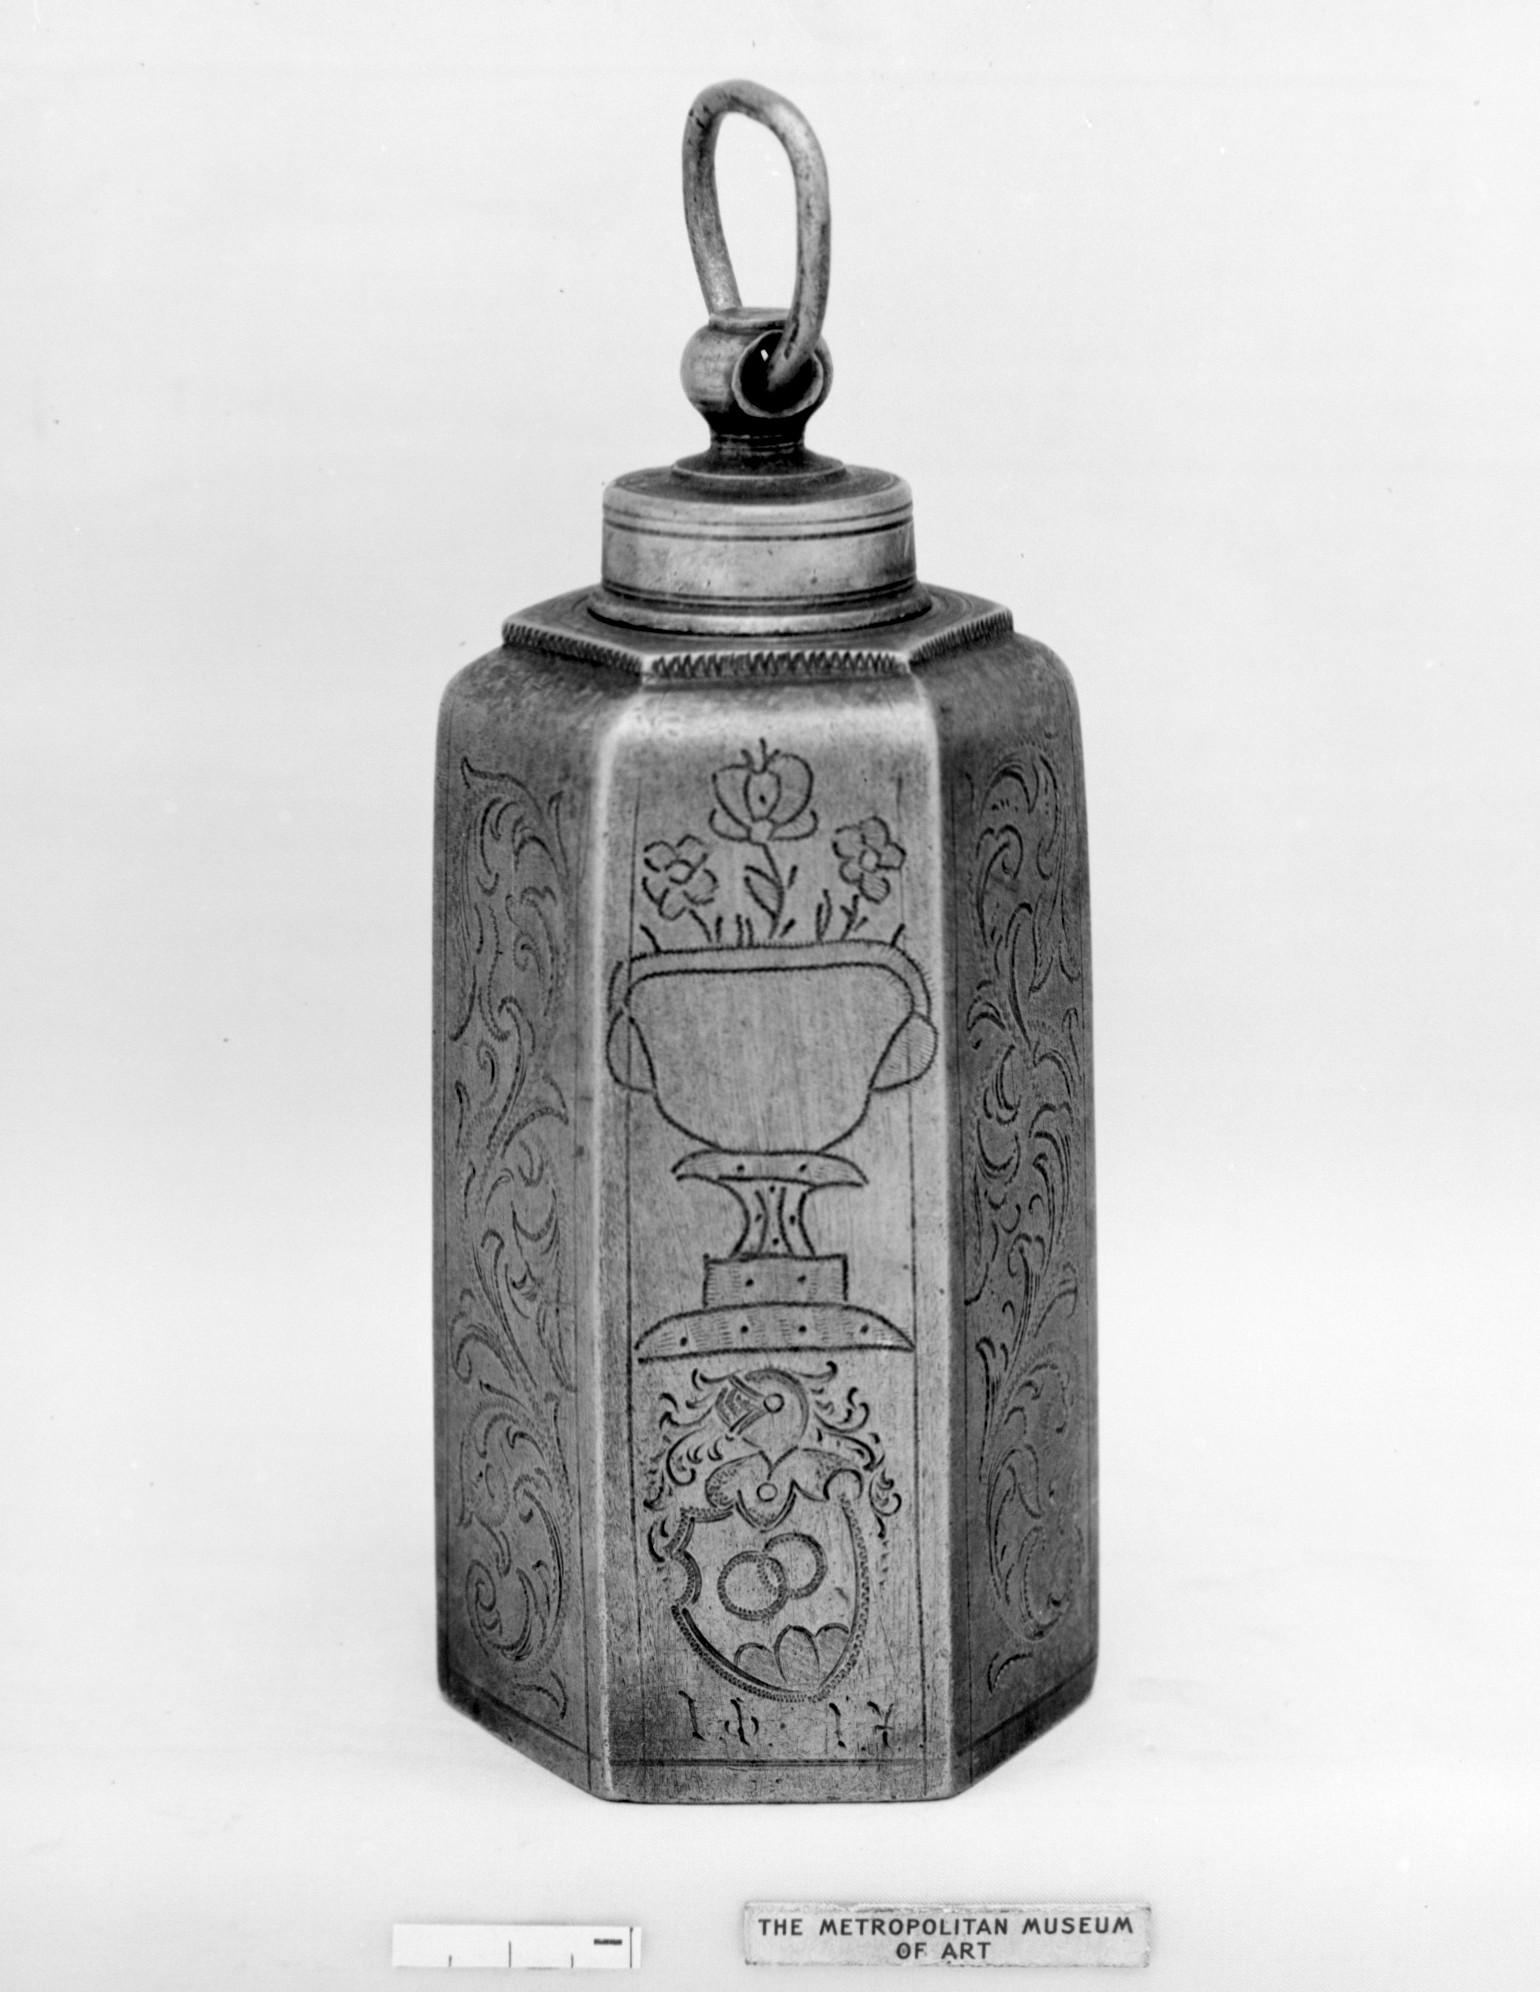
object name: wine can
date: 1601-1700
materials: pewter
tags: flowers,coat of arms